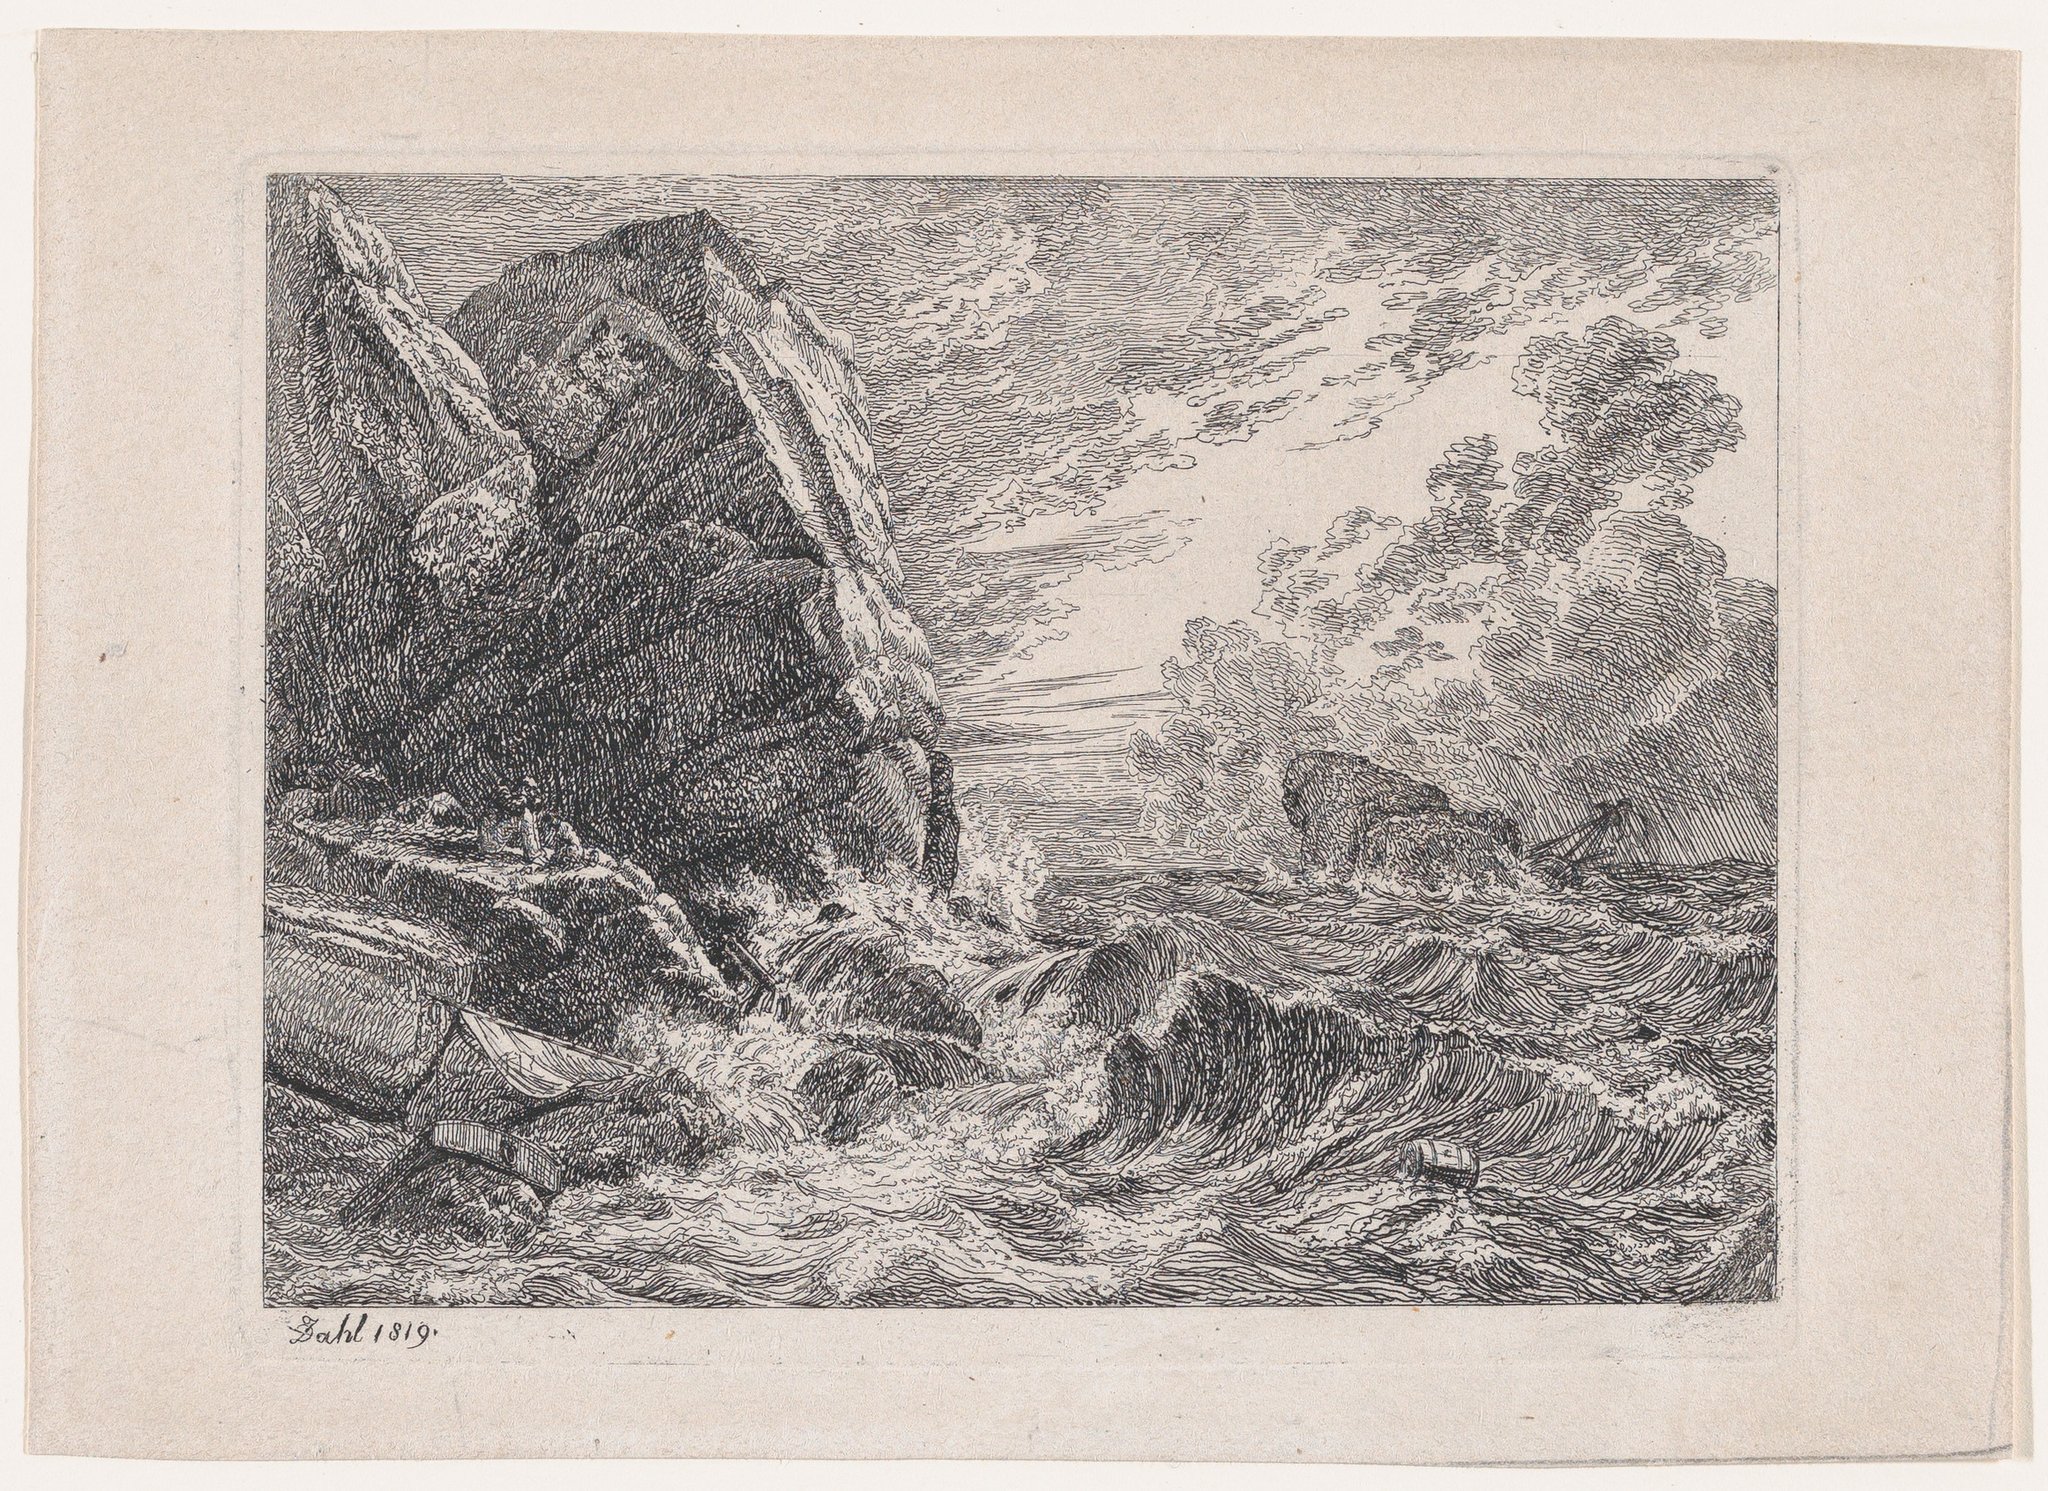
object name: print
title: Shipwreck on a Rocky Shore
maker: johan christian dahl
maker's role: artist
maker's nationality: norwegian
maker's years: 1788-1857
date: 1819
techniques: etching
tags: shipwrecks,seas,waves,ships